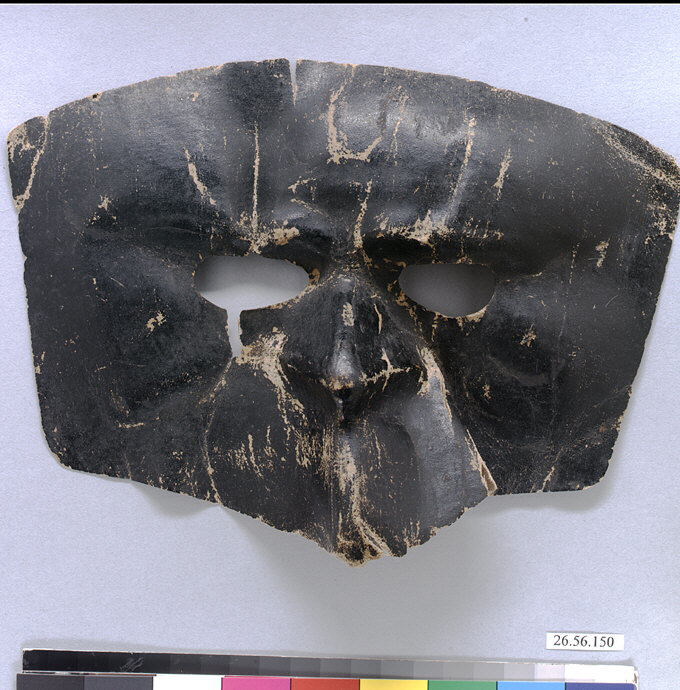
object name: mask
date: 1750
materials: canvas